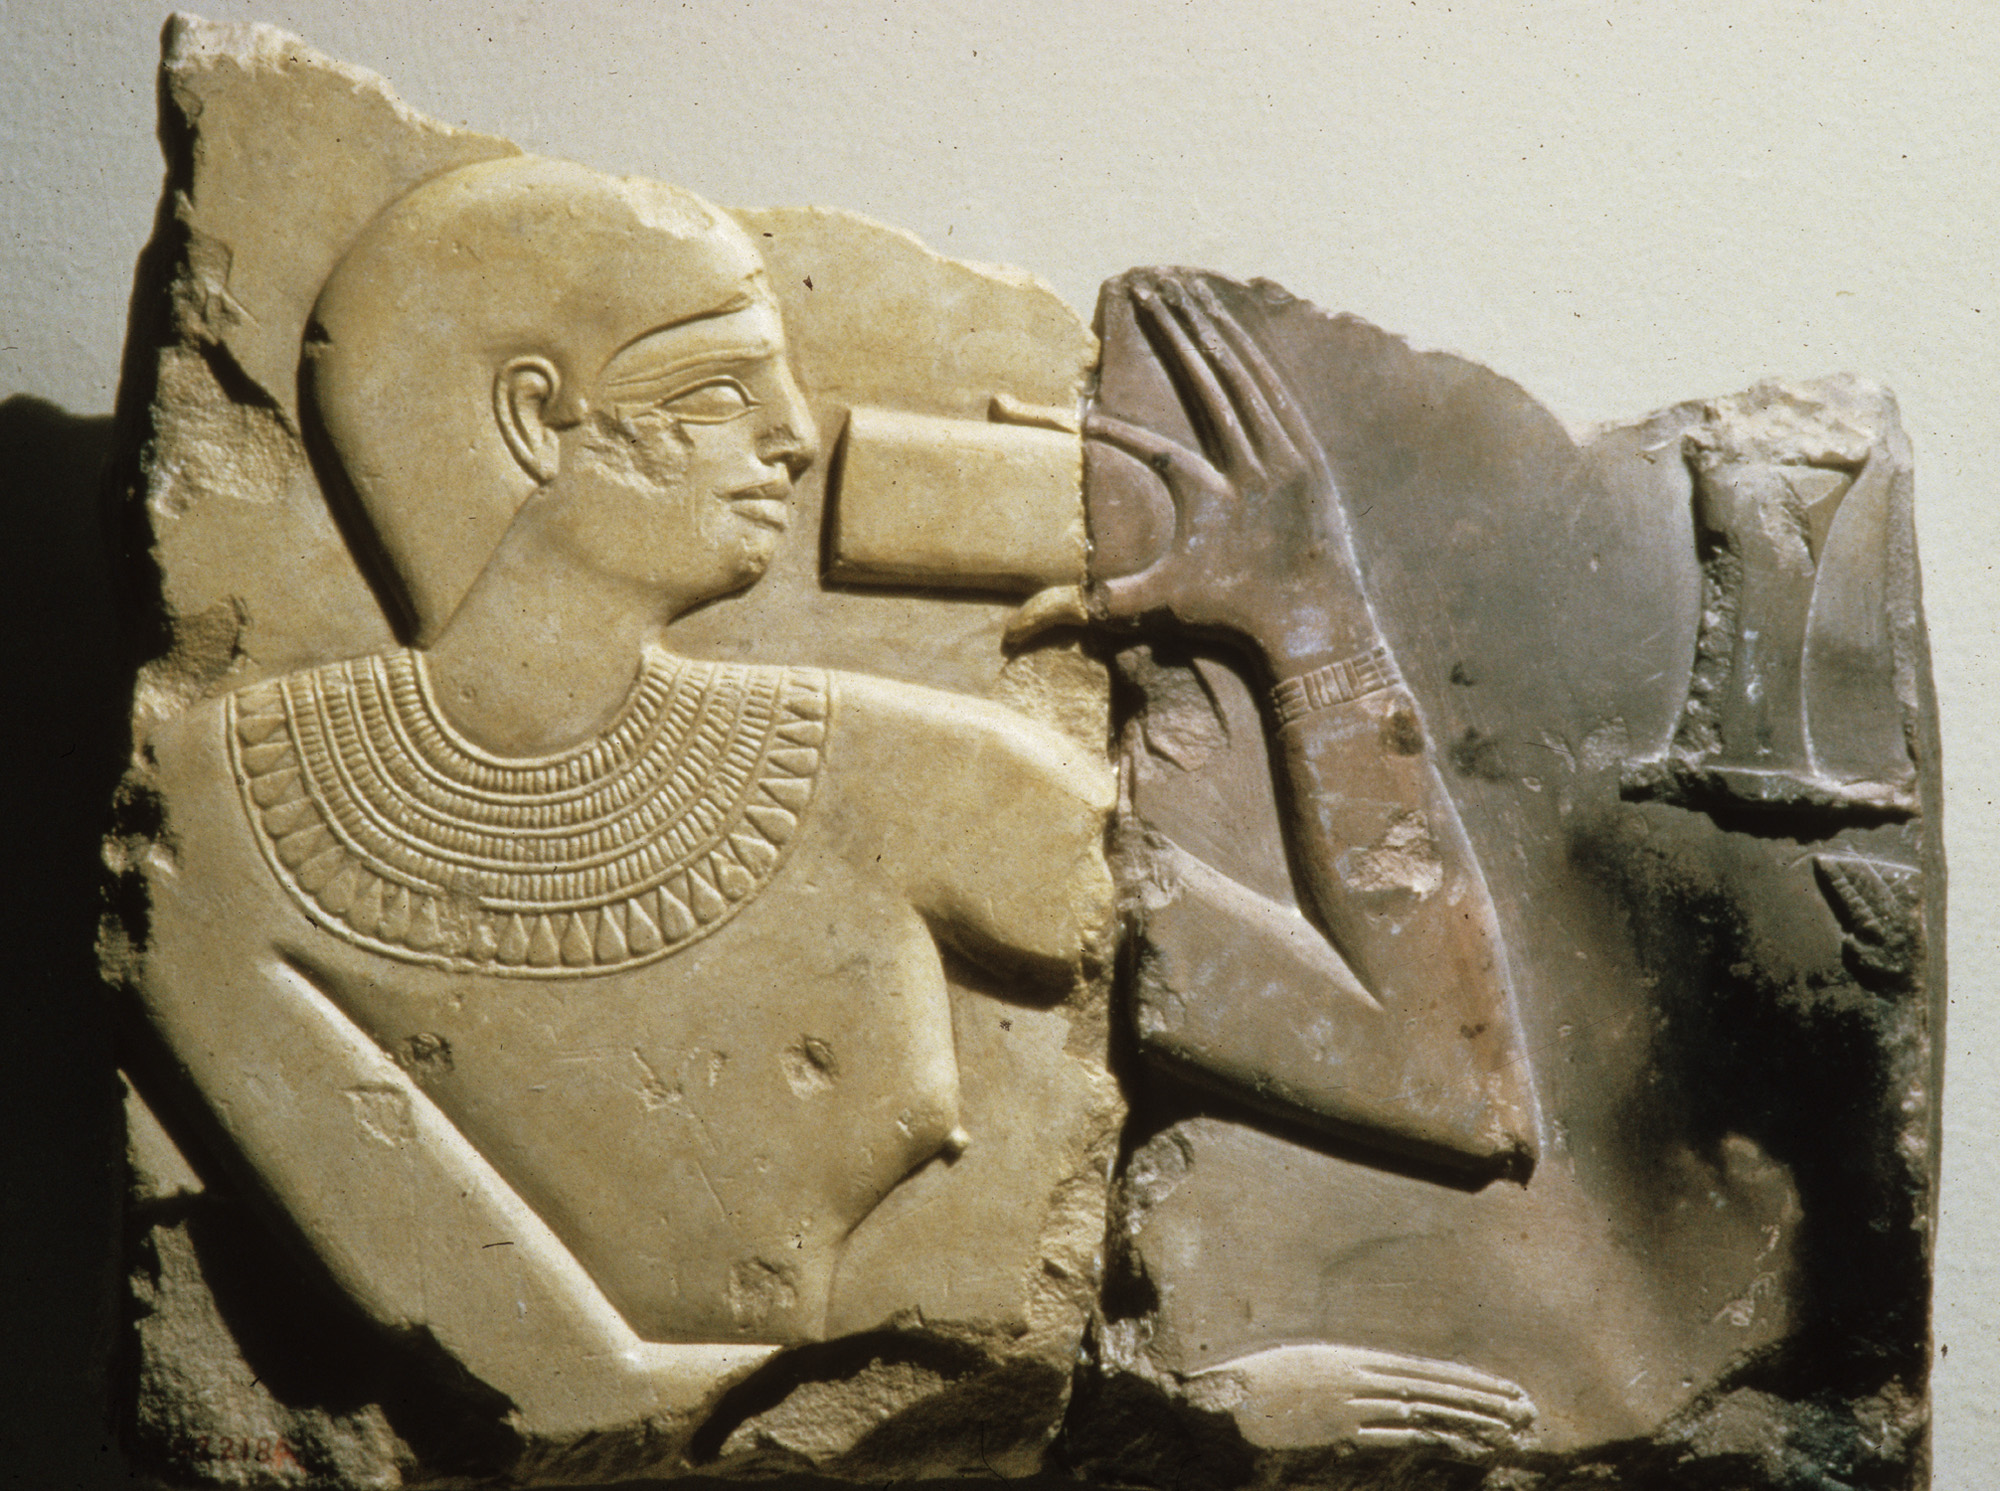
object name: stela, henenu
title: Fragments from stela of the Chief Steward Henenu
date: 2030-2000 BCE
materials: limestone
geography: egypt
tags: female nudes